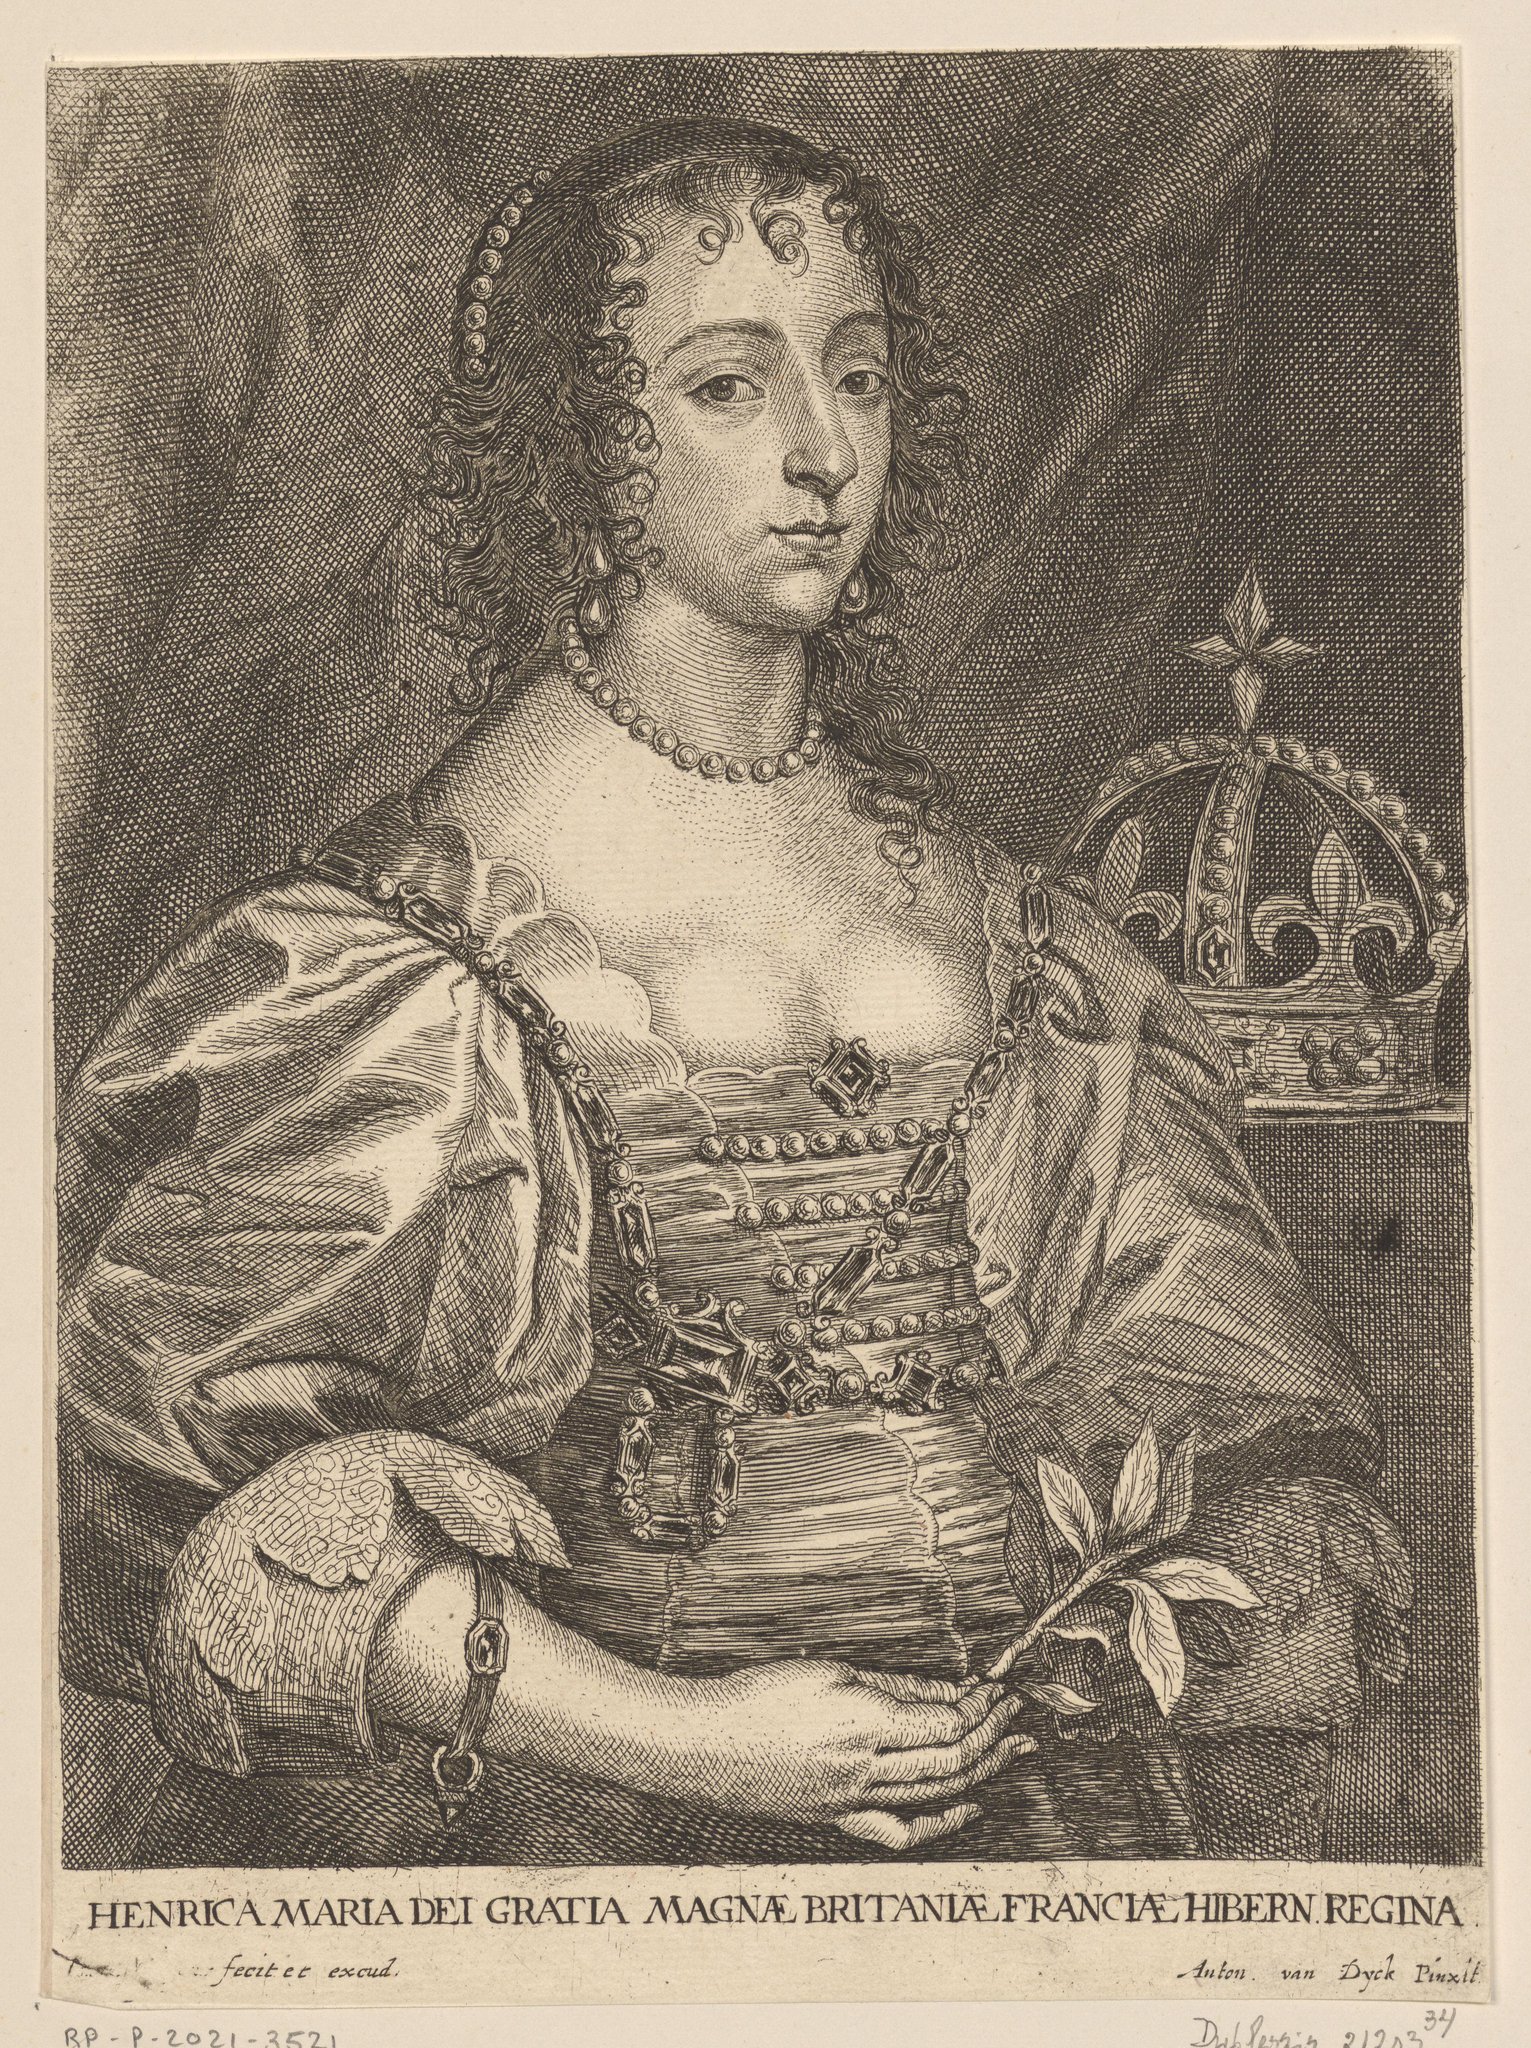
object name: print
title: Portret van Henriëtta Maria van Frankrijk, koningin van Engeland, Schotland en Ierland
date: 1640-1670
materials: paper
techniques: engraving, etching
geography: antwerp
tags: henriëtta maria van frankrijk (koningin van engeland, schotland en ierland), crown (symbol of sovereignty), historical persons - bb - woman, queen